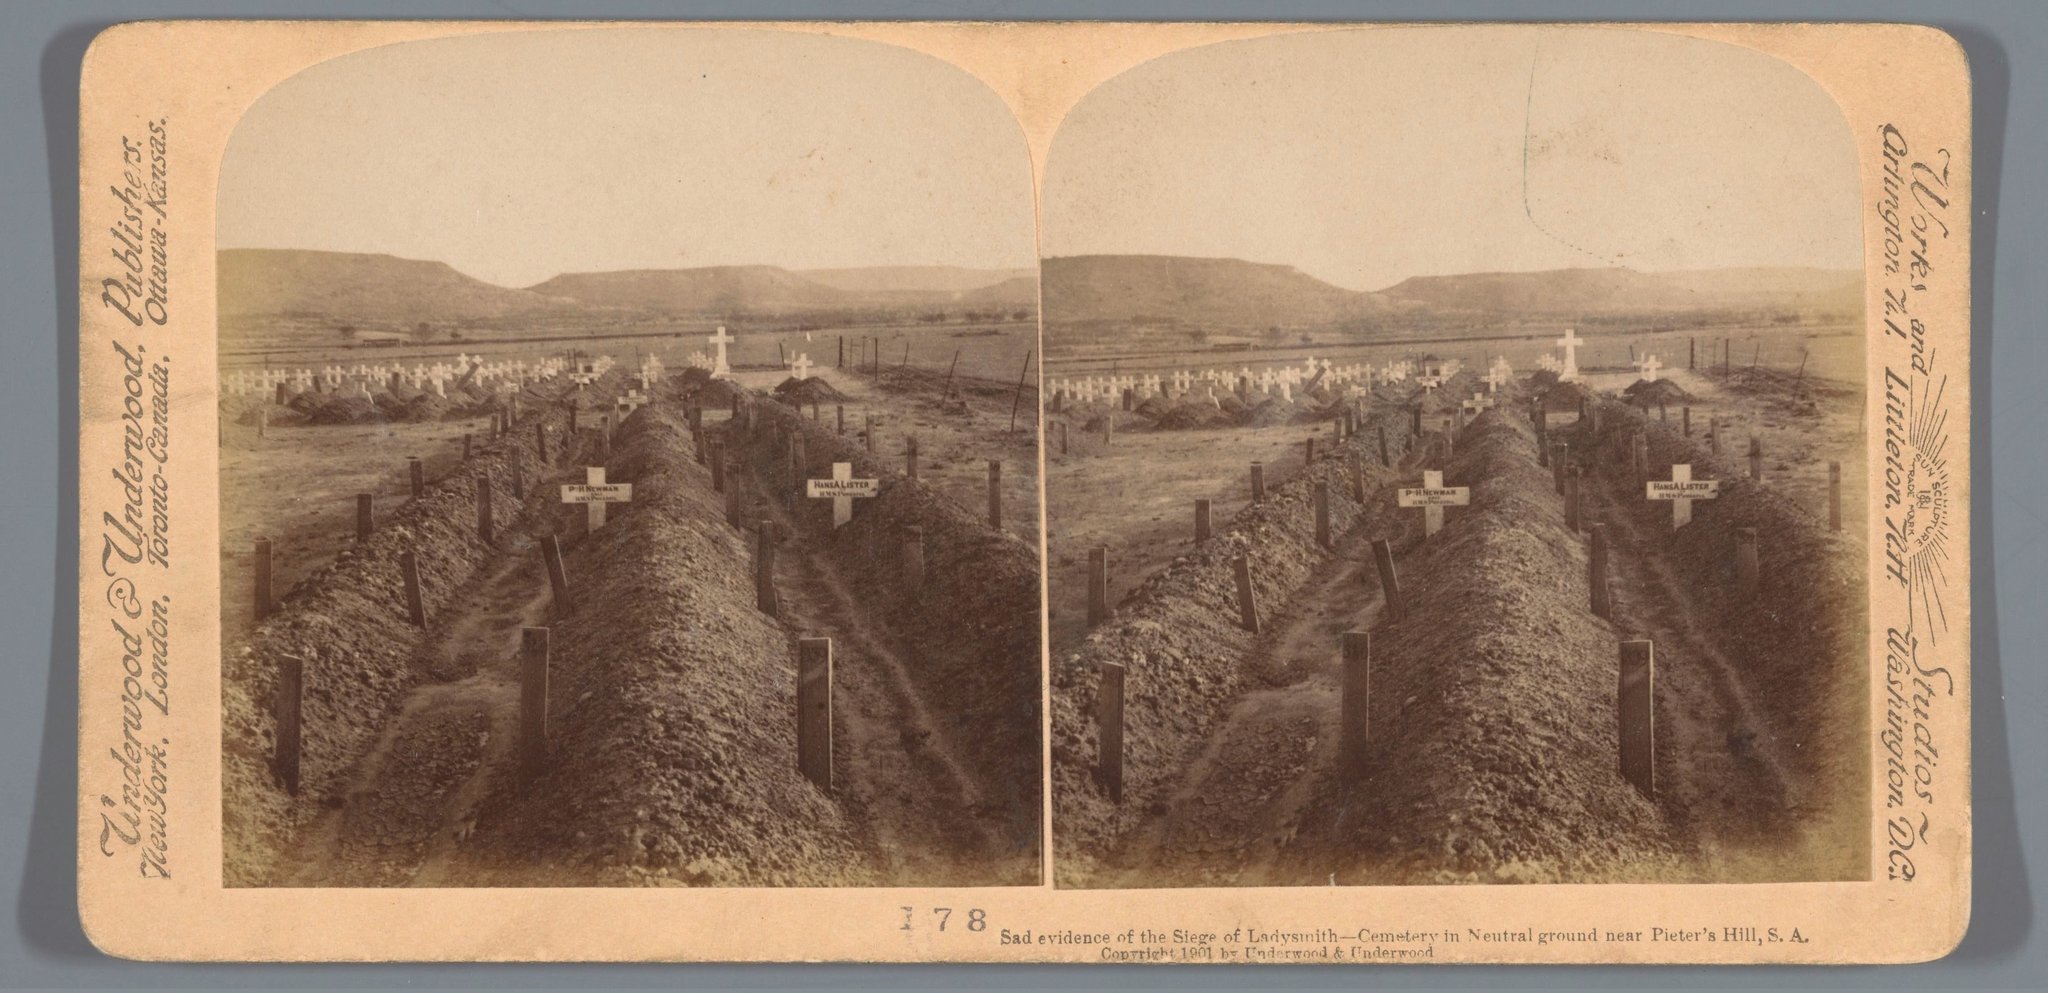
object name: stereograph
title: Begraafplaats op neutraal gebied met slachtoffers van de belegering van Ladysmith, nabij Pieter's Hill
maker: Anonymous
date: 1901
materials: cardboard, paper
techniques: albumen print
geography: new york city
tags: churchyard, cemetery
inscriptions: inscription, inscription: ‘Works and Studios ~/ Arlington, N.J. Littleton, N.H. Washington, D.C.’, number: ‘178’, copyright notice: ‘Copyright 1901 by Underwood & Underwood.’